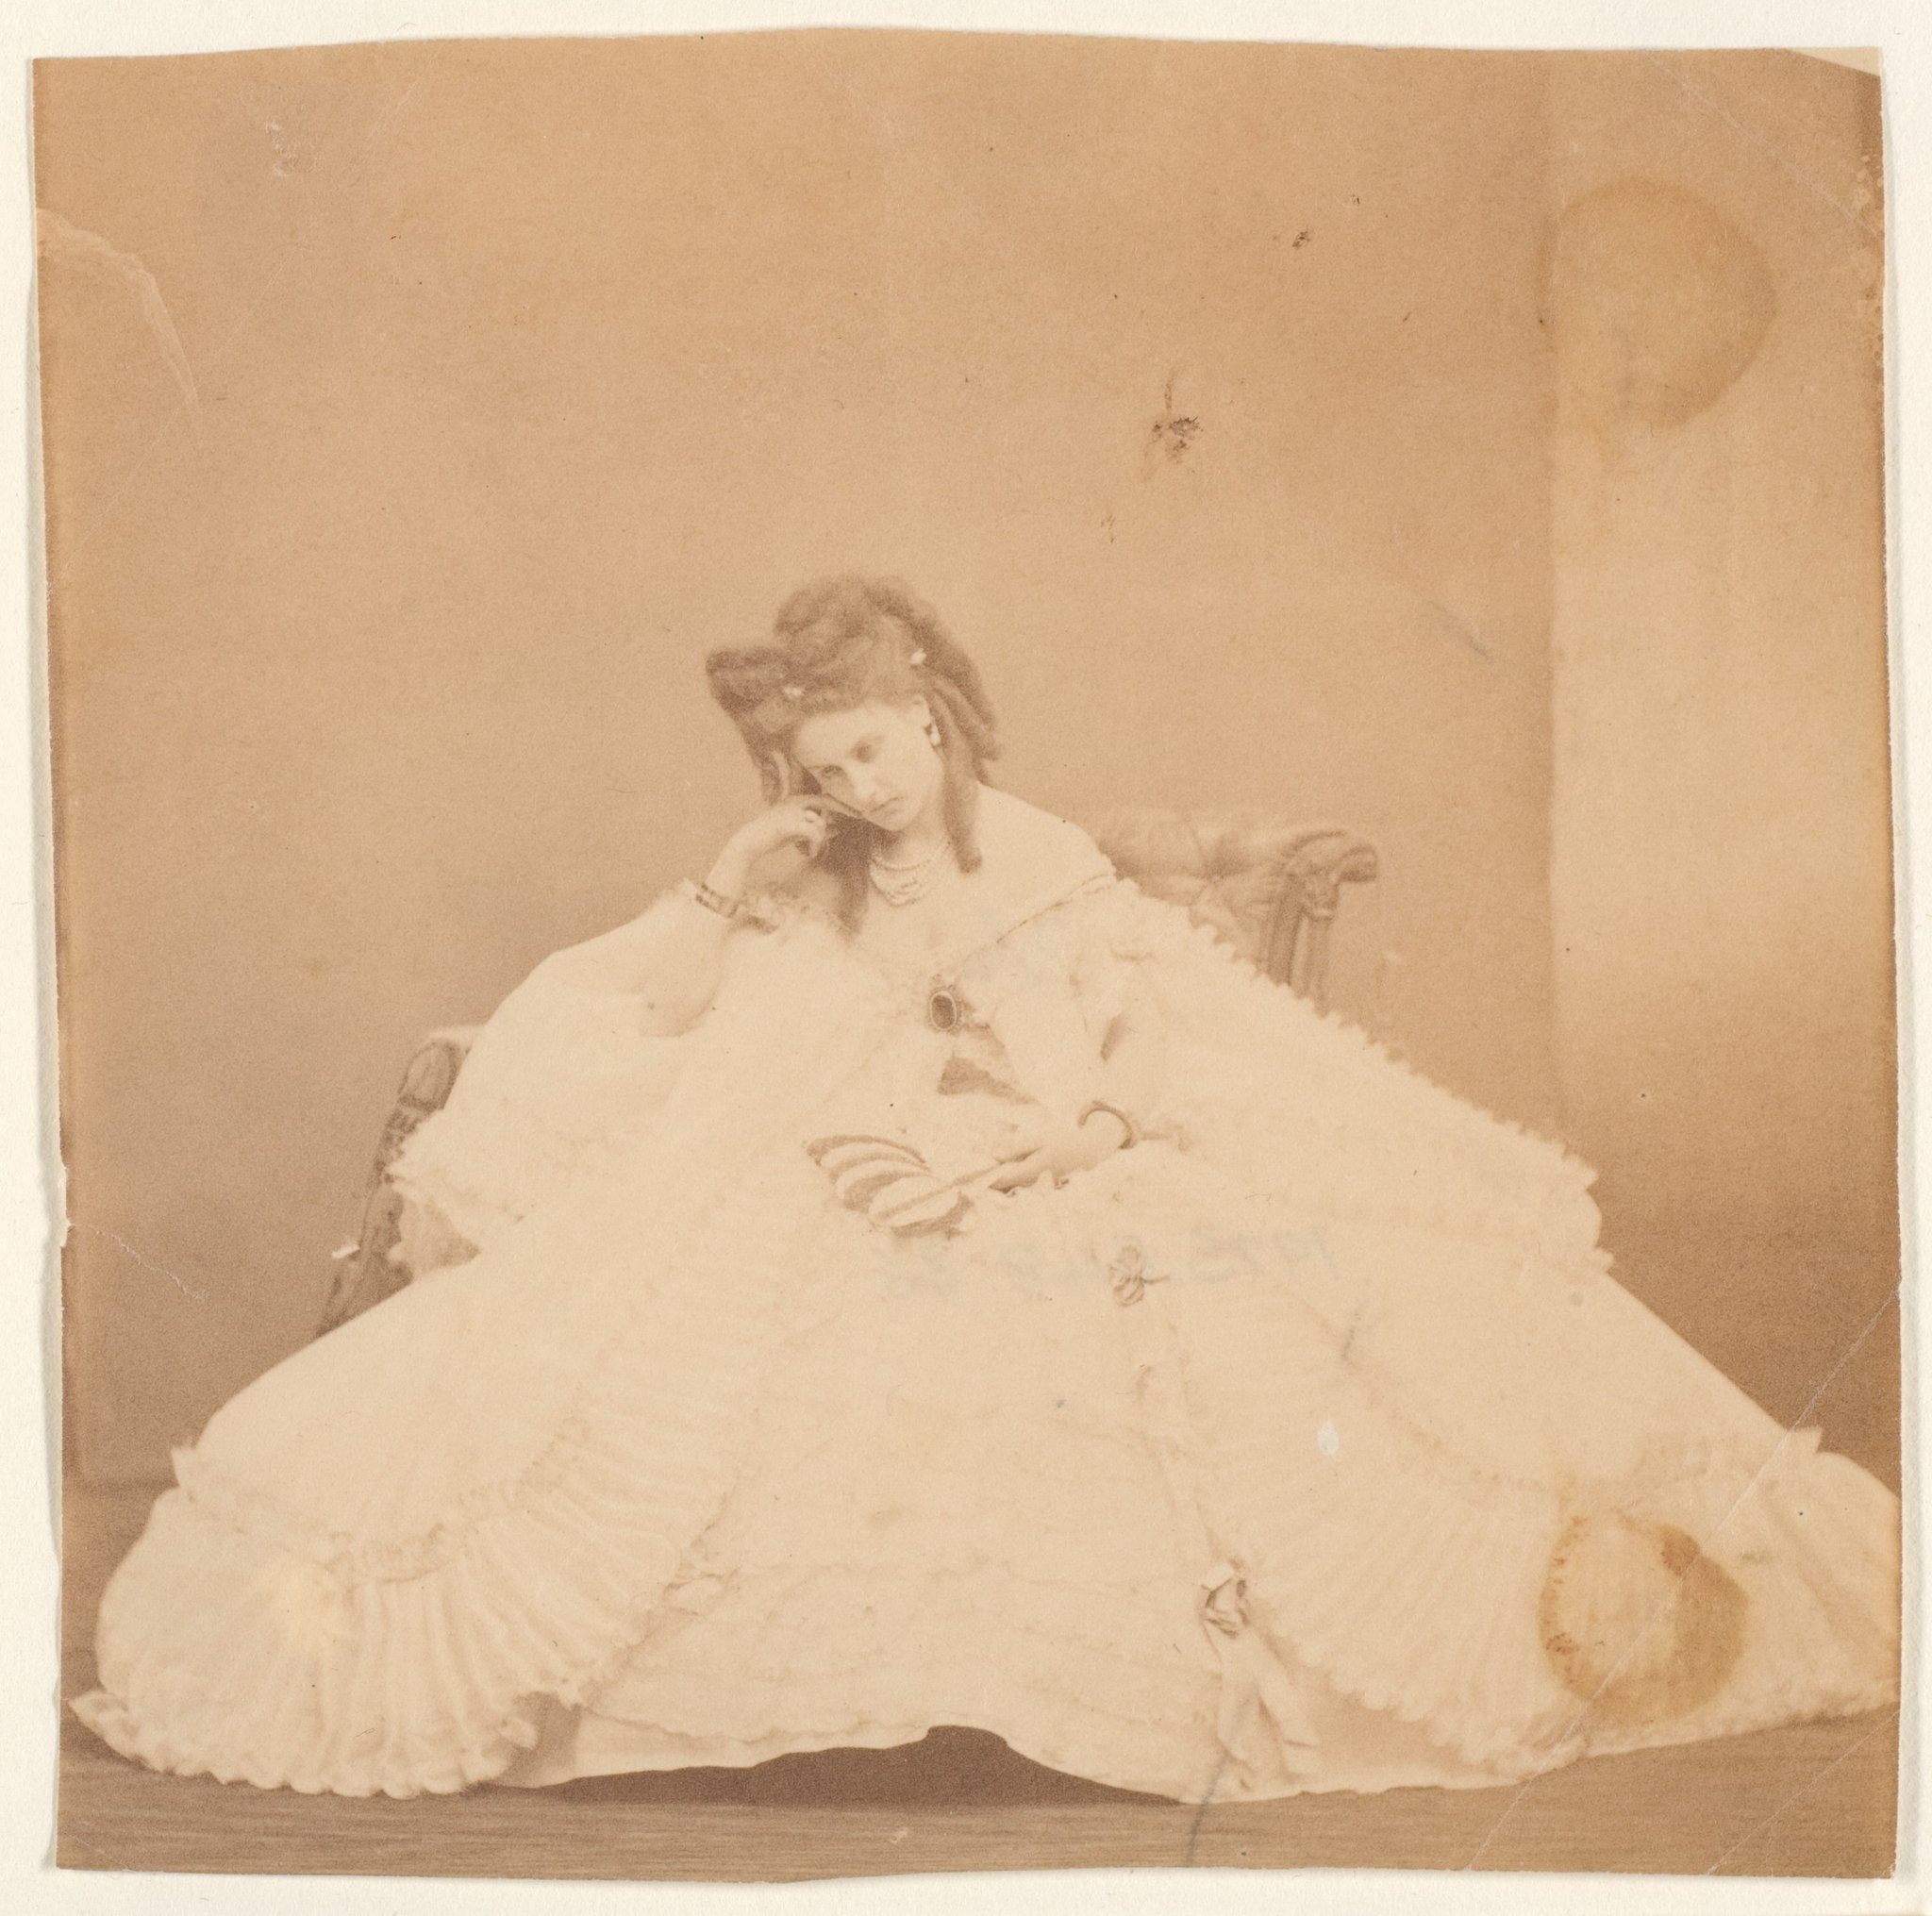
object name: photograph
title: Le peignoir plisié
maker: pierre-louis pierson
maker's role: artist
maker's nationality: french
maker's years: 1822-1913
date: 1860-1869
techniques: albumen silver print, glass negative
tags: portraits,women